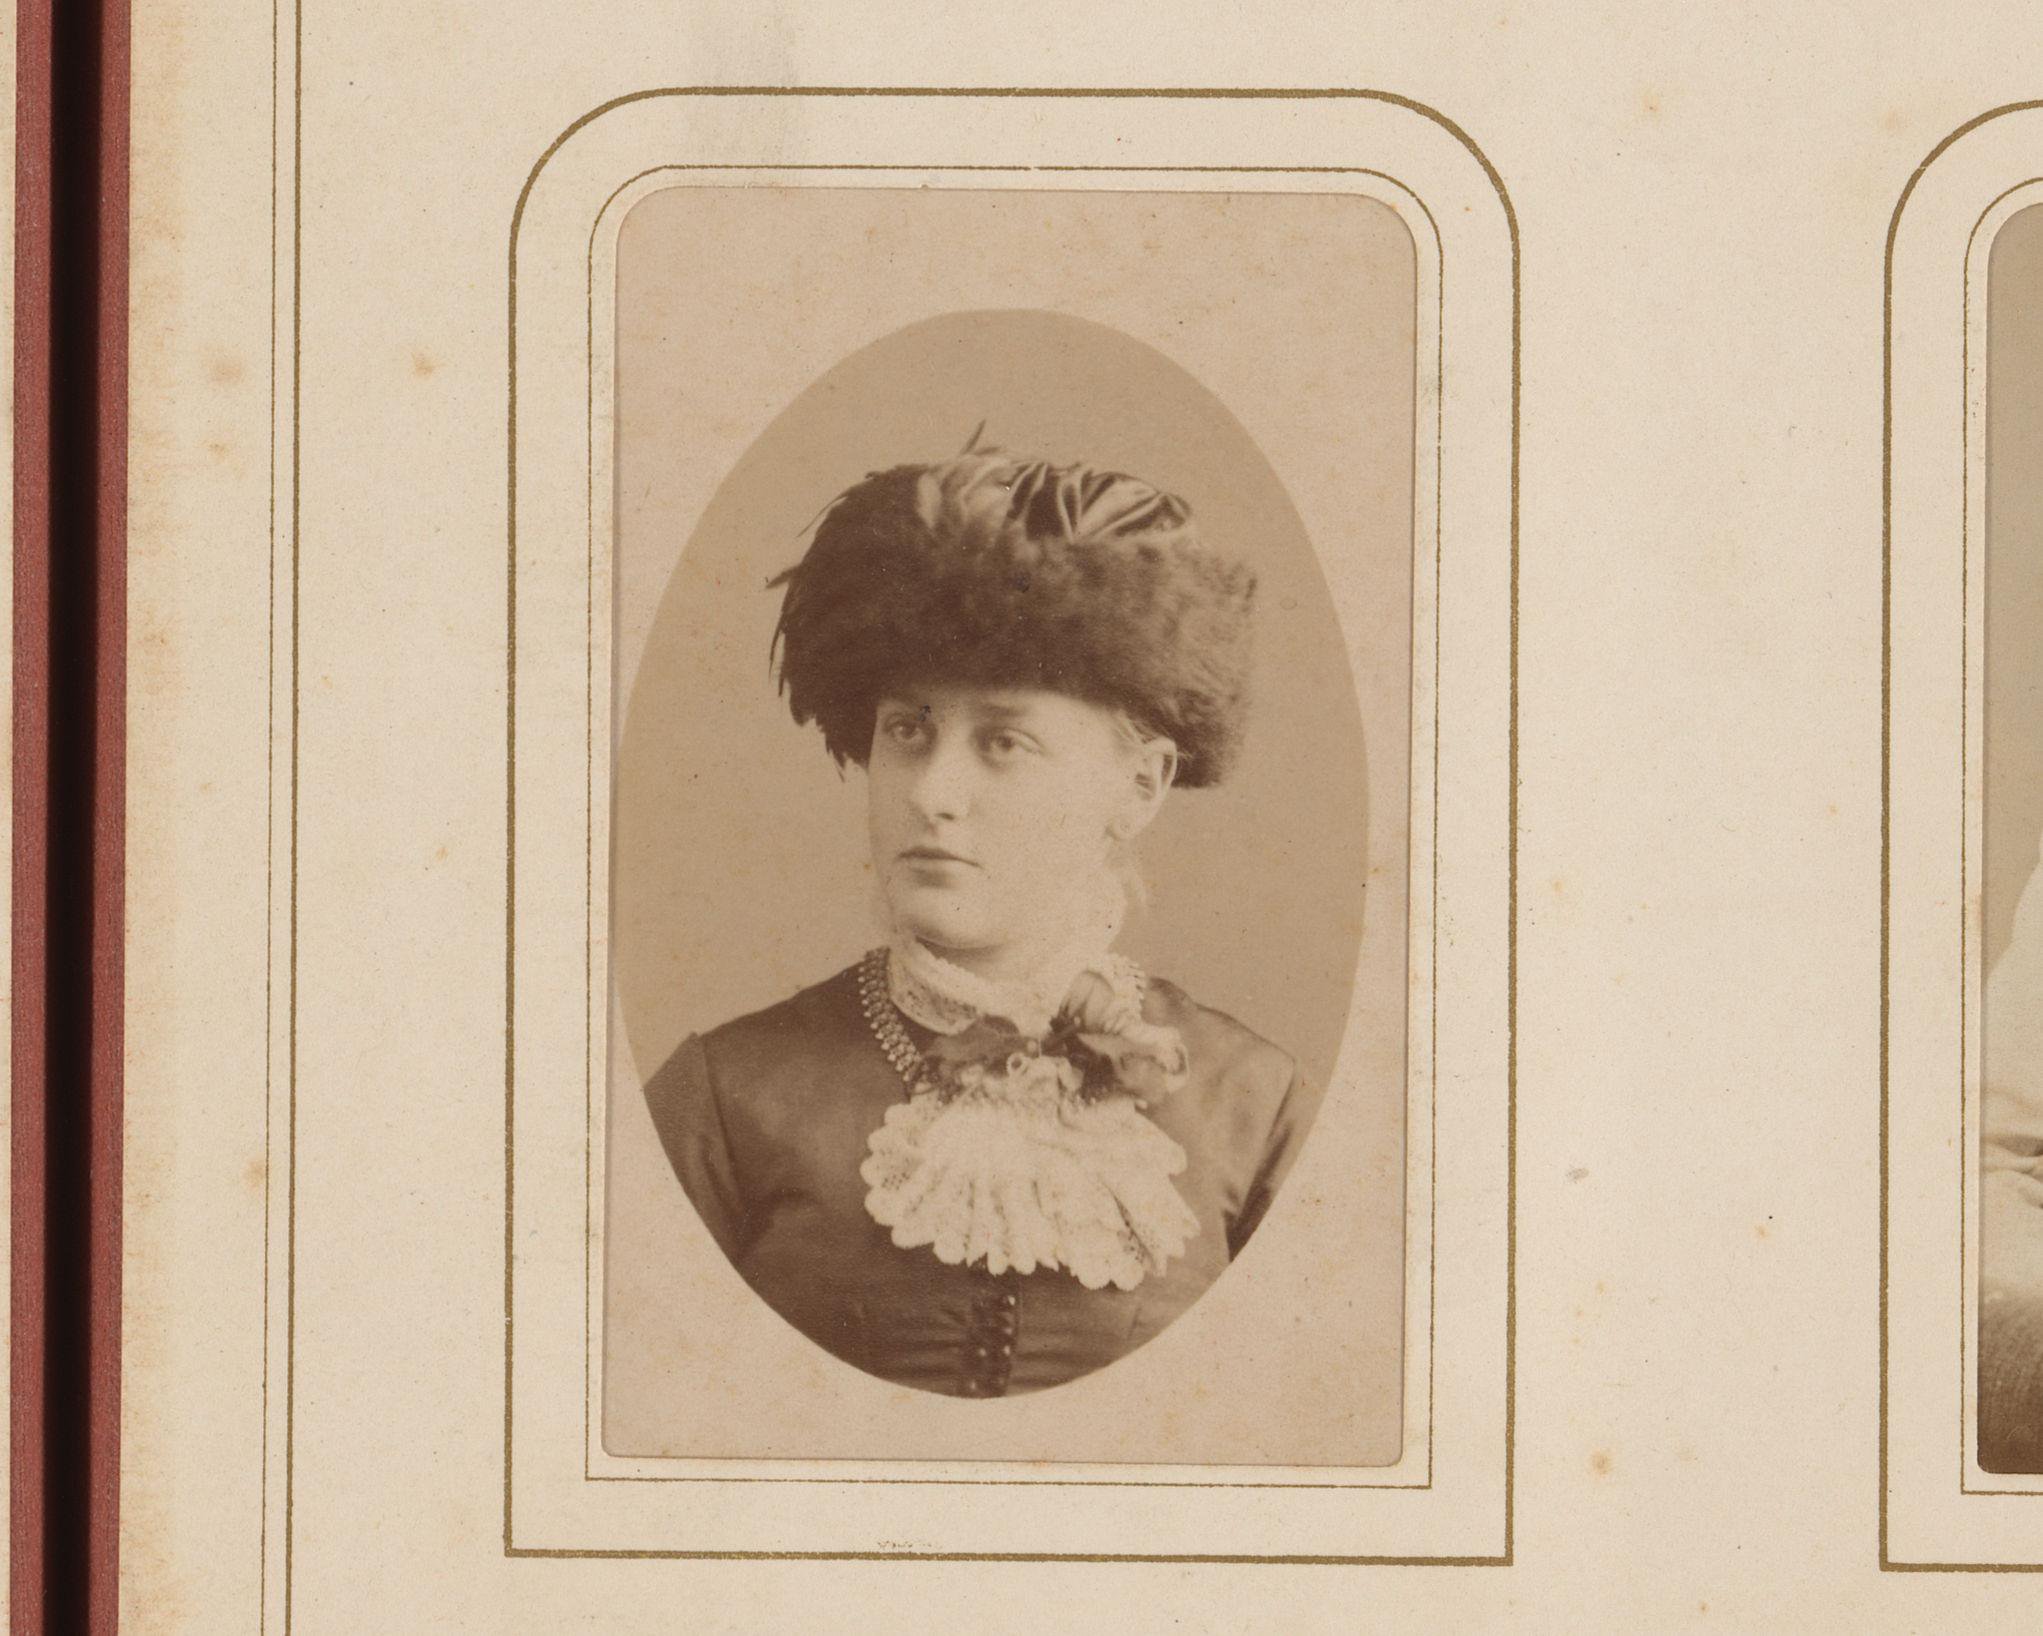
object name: album leaf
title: Portret van een jonge vrouw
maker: max büttinghausen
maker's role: fotograaf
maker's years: 1847-1906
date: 1873-1886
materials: cardboard, photographic support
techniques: albumen print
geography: amsterdam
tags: adolescent, young woman, maiden, historical persons - bb - woman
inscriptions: inscription: ‘M. Büttinghausen/ Photographisch artistisch Atelier/ Amsterdam/ Singel bij het Koningsplein No. 512./ SPECIALITEIT IN VERGROOTINGEN.’